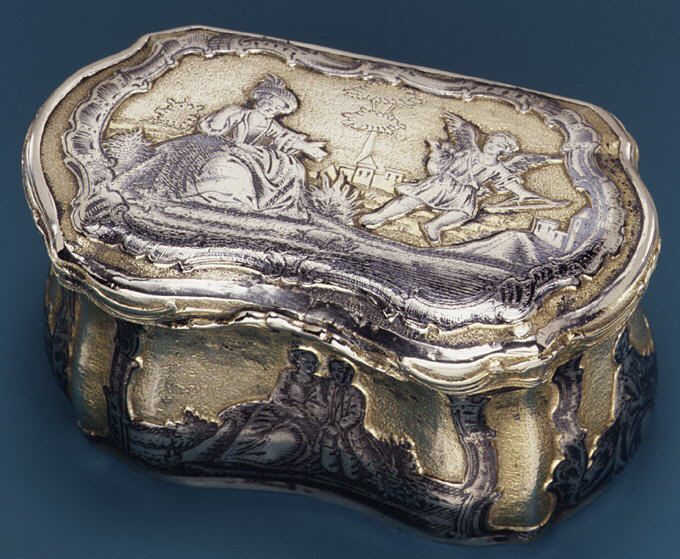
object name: casket or toilet box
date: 1770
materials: niello, silver gilt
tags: men,women